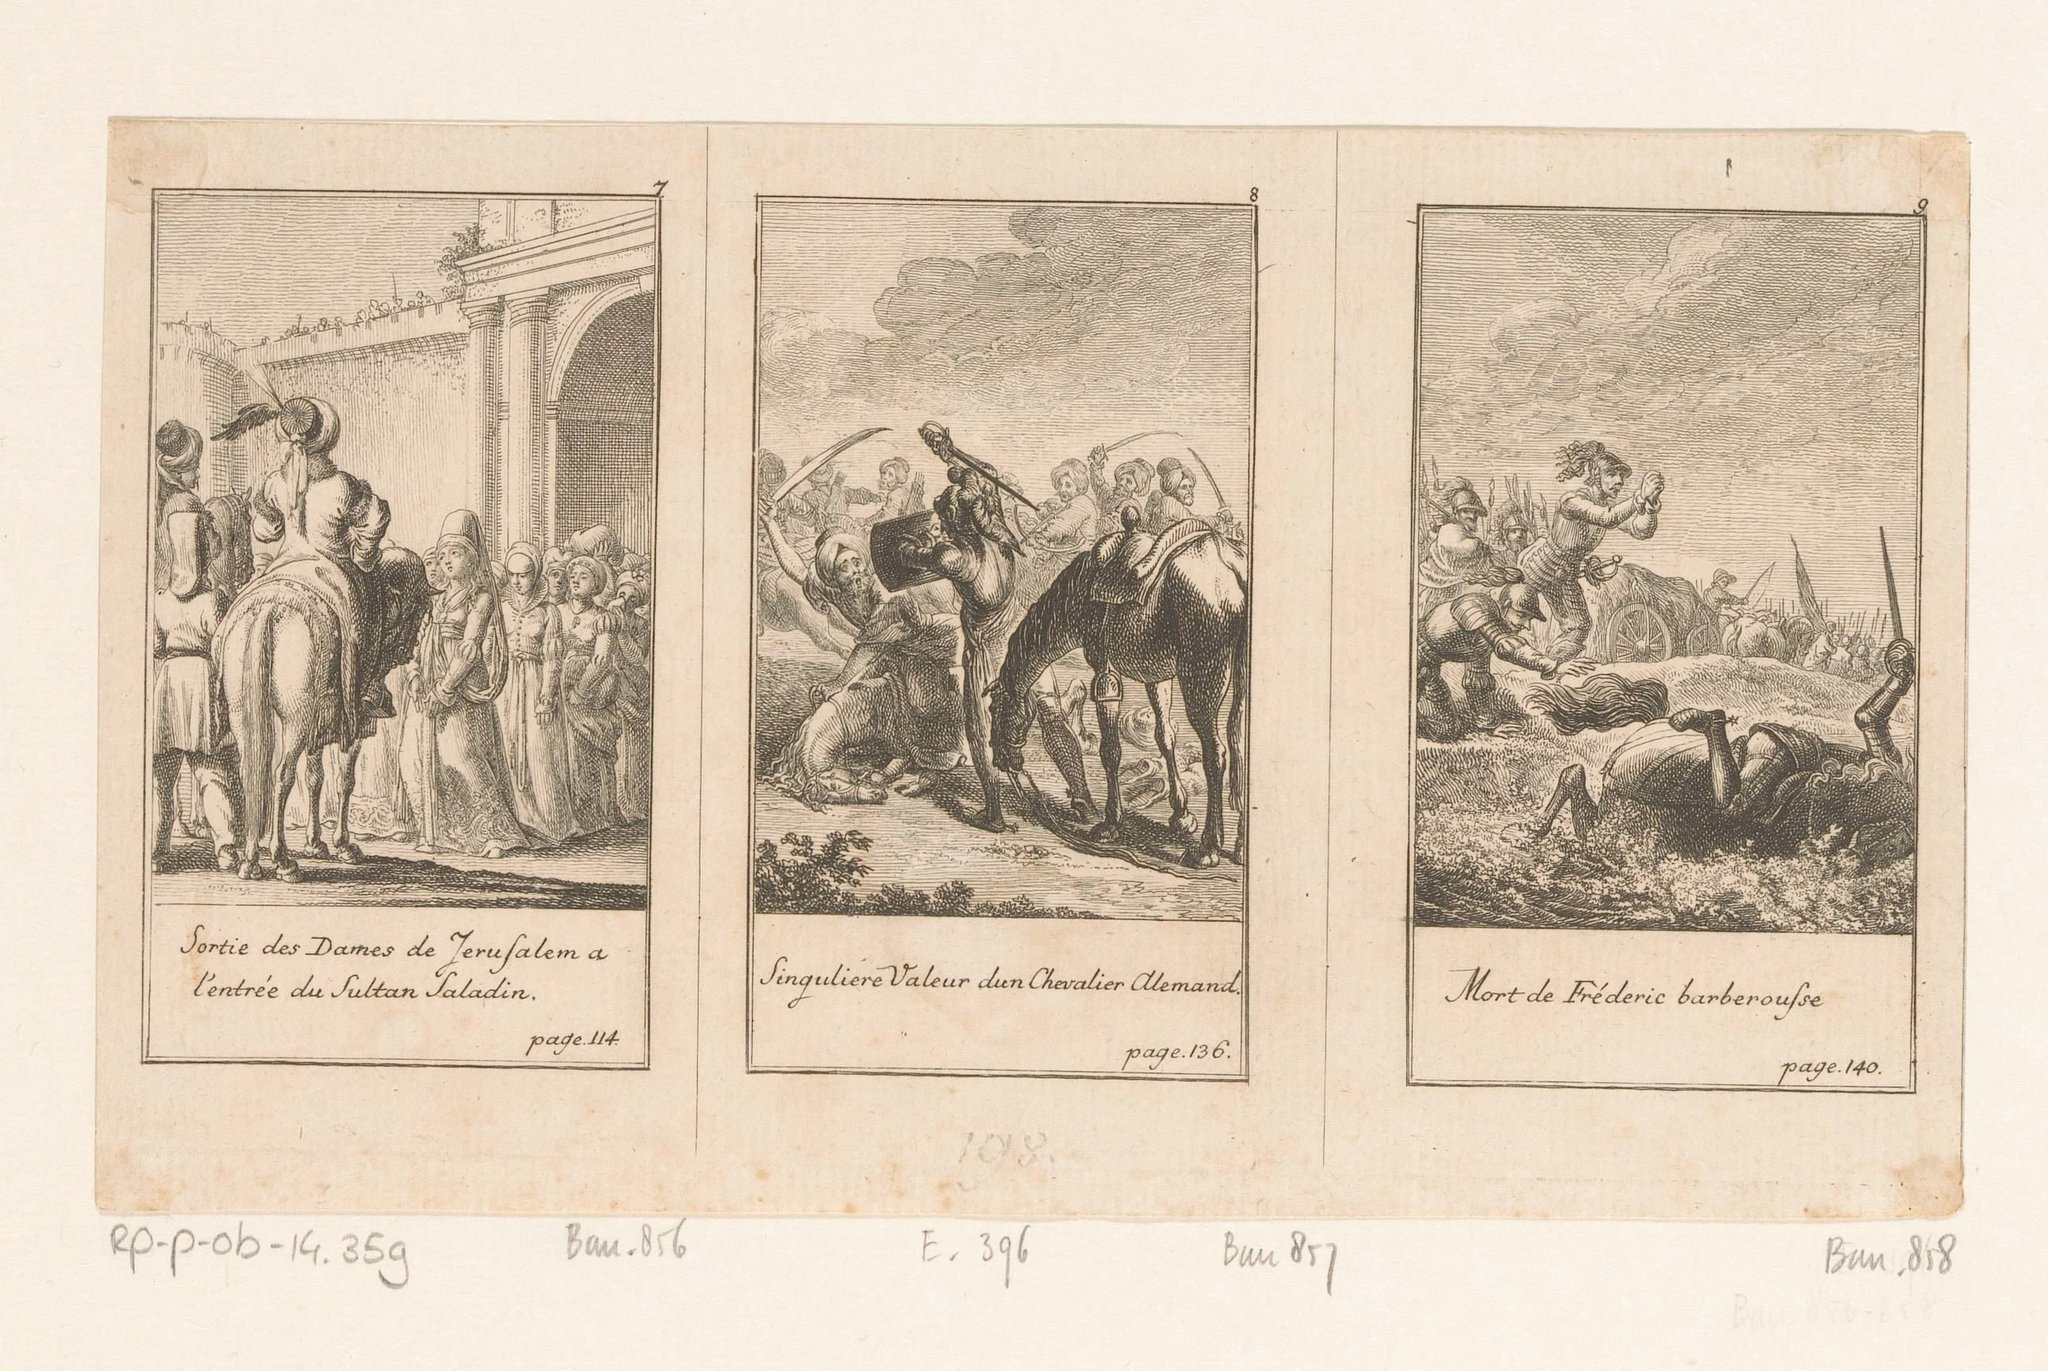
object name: print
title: Drie voorstellingen uit Histoire des Croïsades van Maier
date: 1781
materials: paper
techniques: etching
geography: gotha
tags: protective weapons: shield, adult woman, asiatic races and peoples: turks, militant proselytizing: religious war, crusade, etc., horse, city-gate, dying from the effects of a fall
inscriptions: collector's mark: Lugt 2228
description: Rechtsboven genummerd van zeven tot en met negen, met onderschrift in het Frans. Afgebeeld zijn: Saladin ziet toe hoe de christelijke vrouwen Jeruzalem verlaten (7), de anekdote van de Duitse ridder (8) en de dood van keizer Frederik I (9).